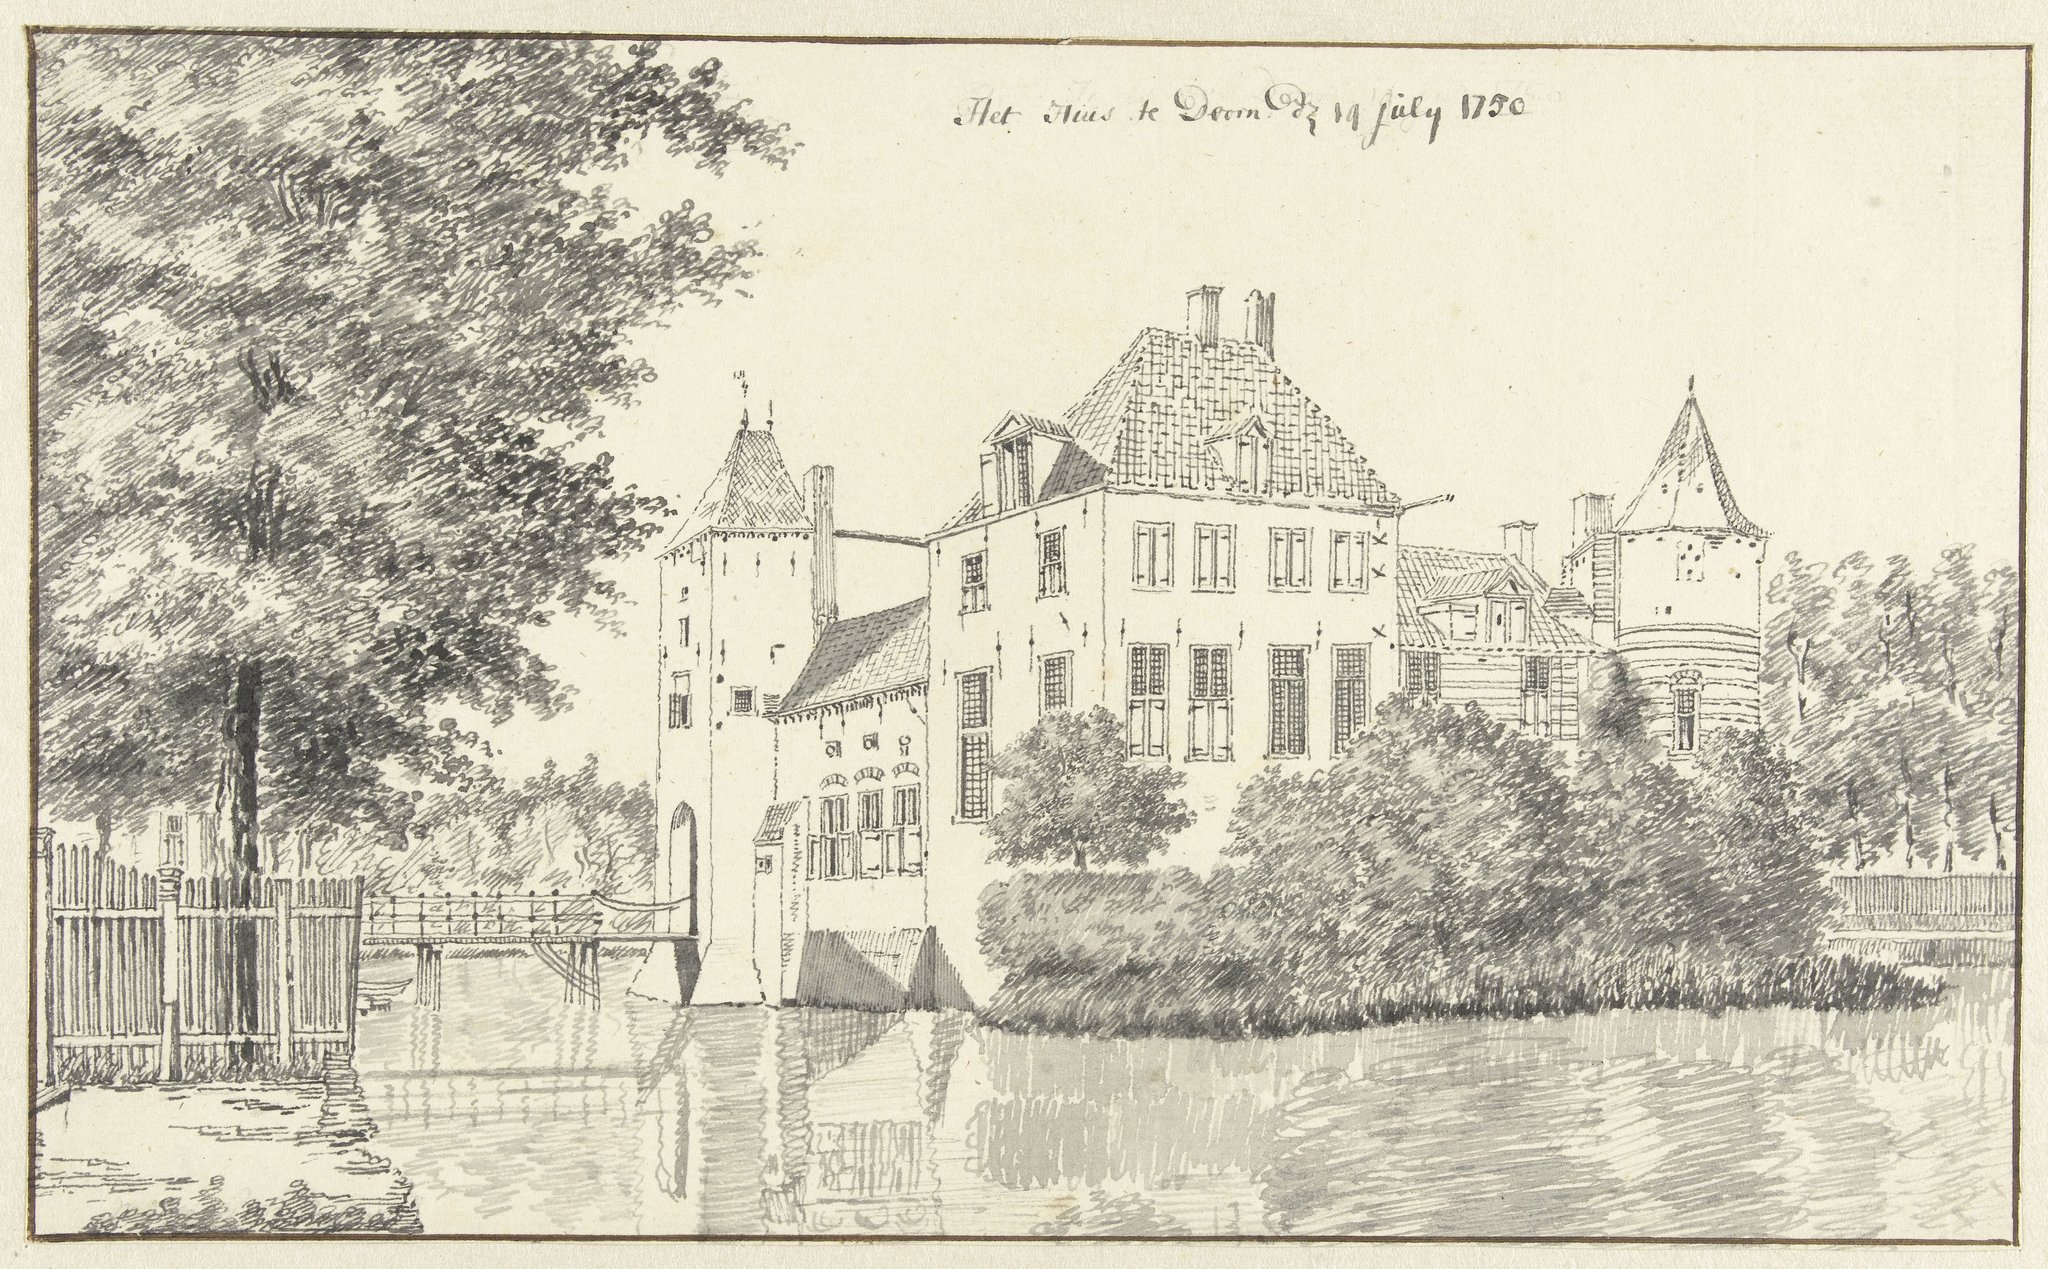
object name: drawing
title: Het Huis te Doorn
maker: jan de beijer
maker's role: draughtsman, print maker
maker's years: 1703-1780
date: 1750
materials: ink, paper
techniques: brush, pen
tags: castle